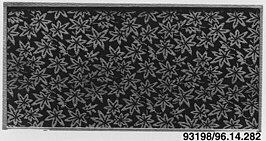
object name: piece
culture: japanese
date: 1701-1900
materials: silk